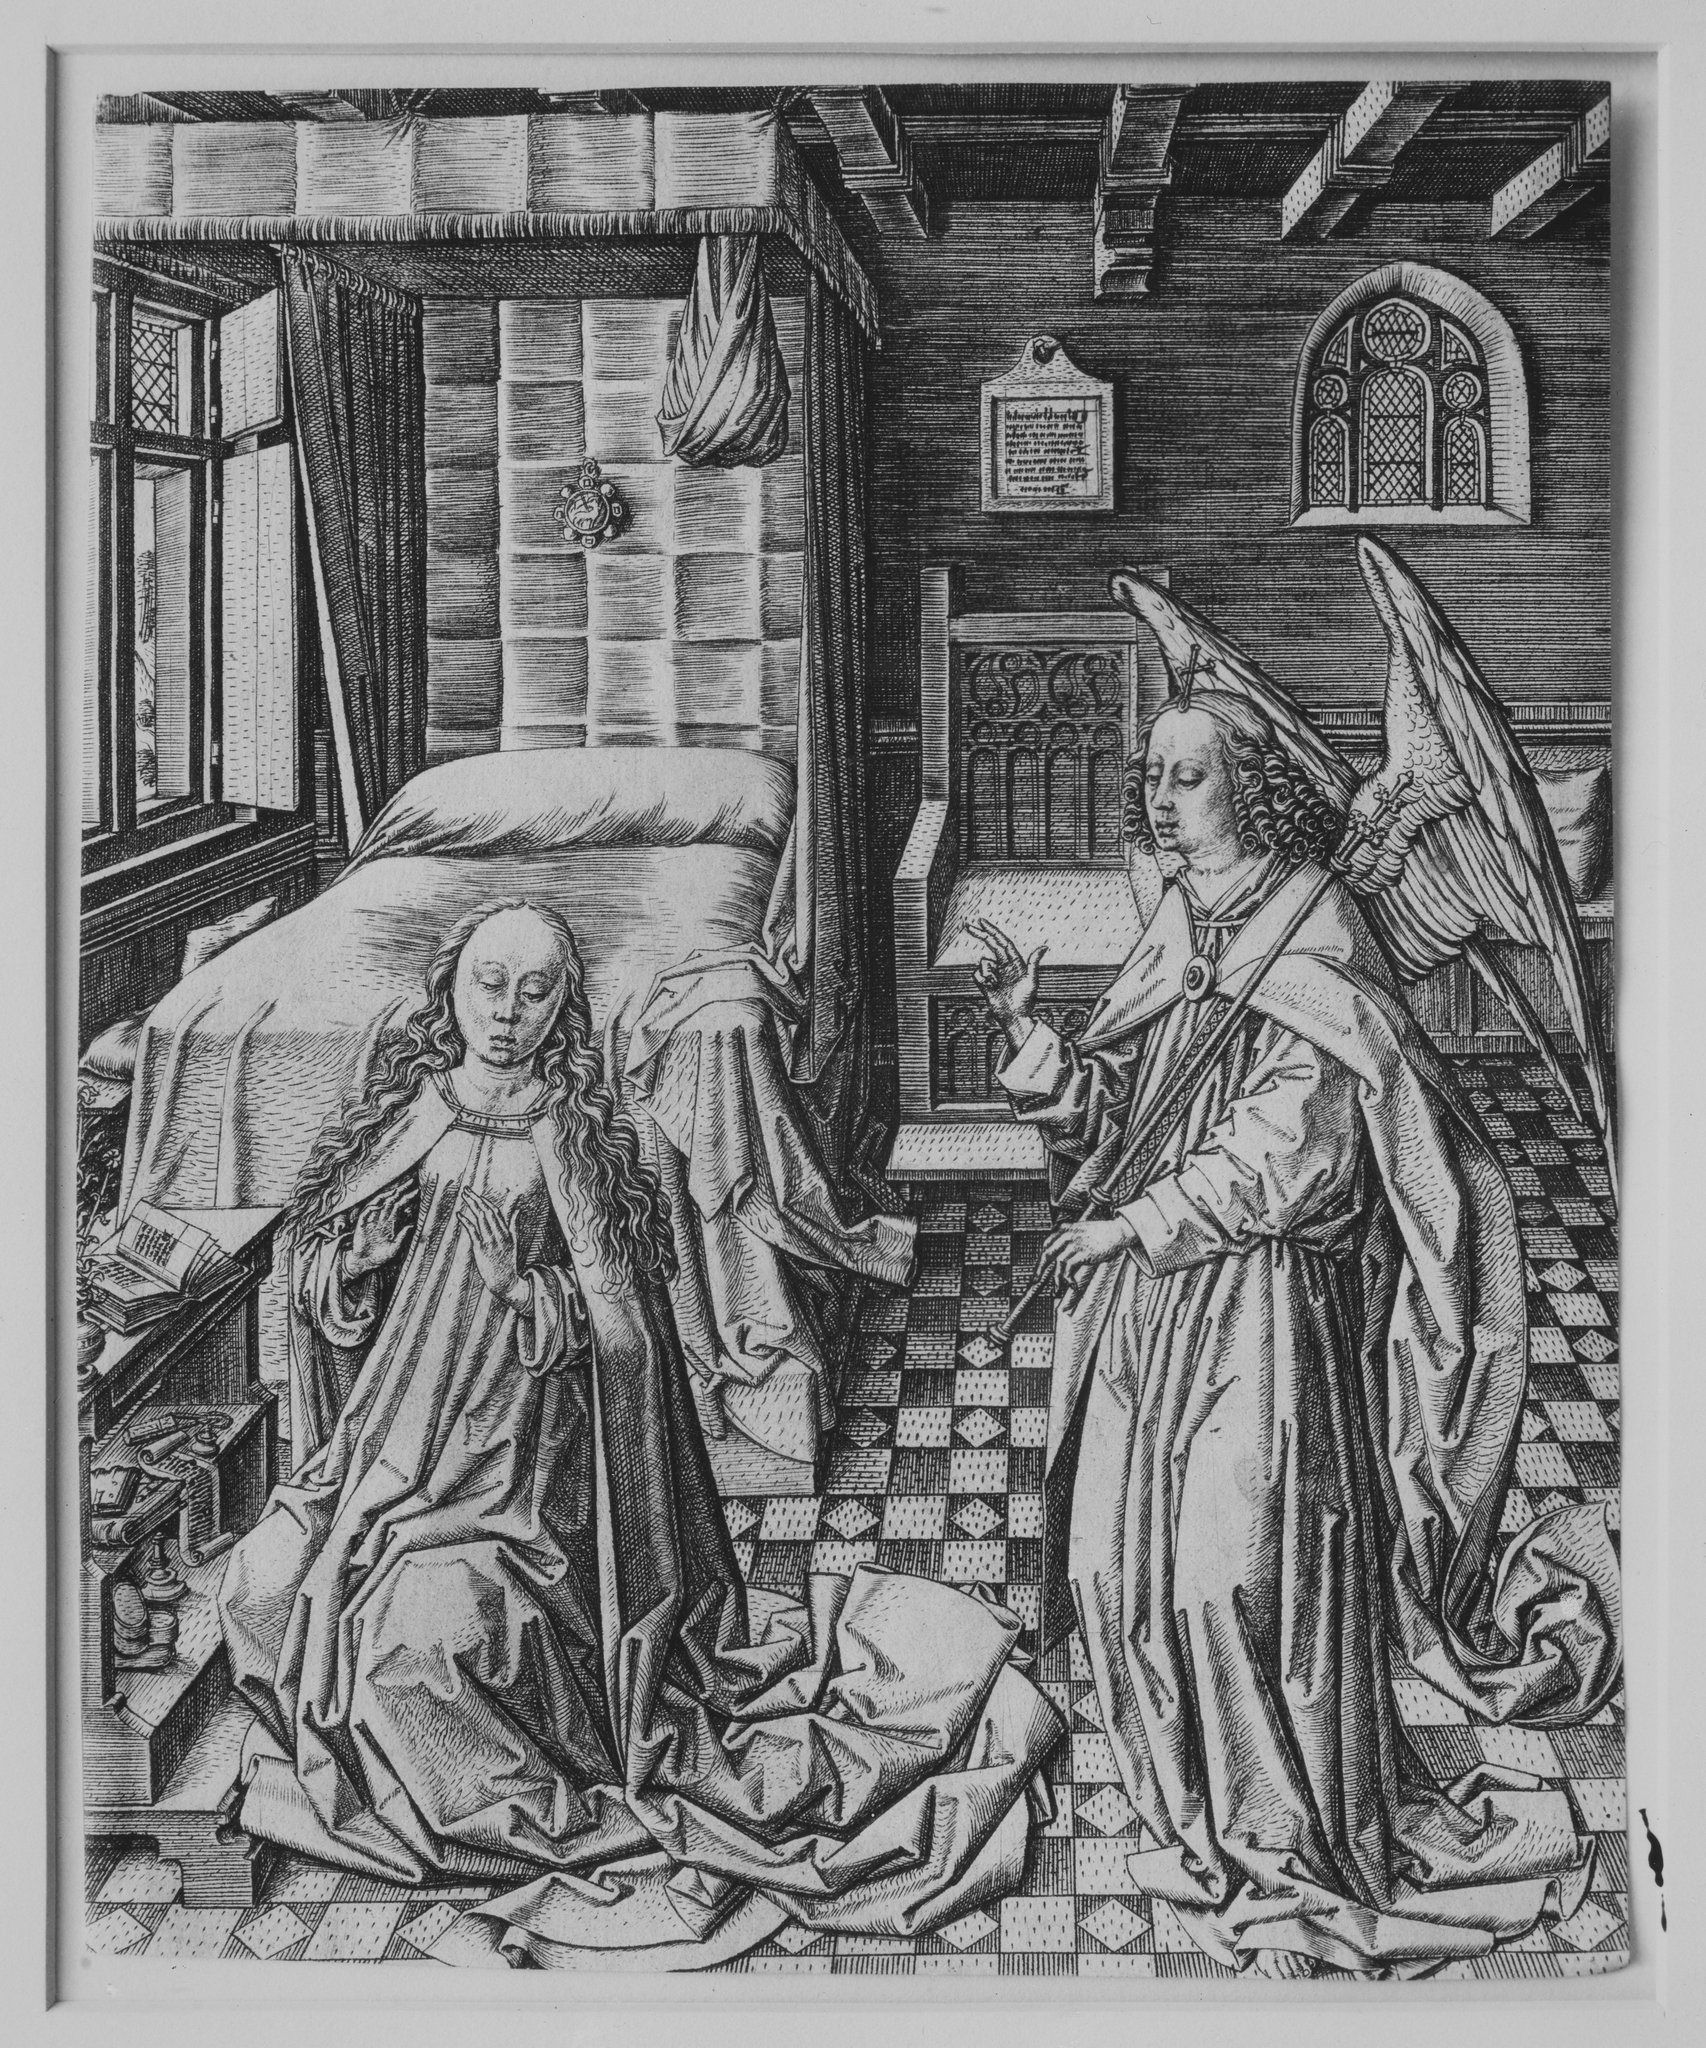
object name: print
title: The Annunciation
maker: master fvb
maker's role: artist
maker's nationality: netherlandish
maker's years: 1475-1500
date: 1467-1500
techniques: engraving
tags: women,angels,annunciation,beds